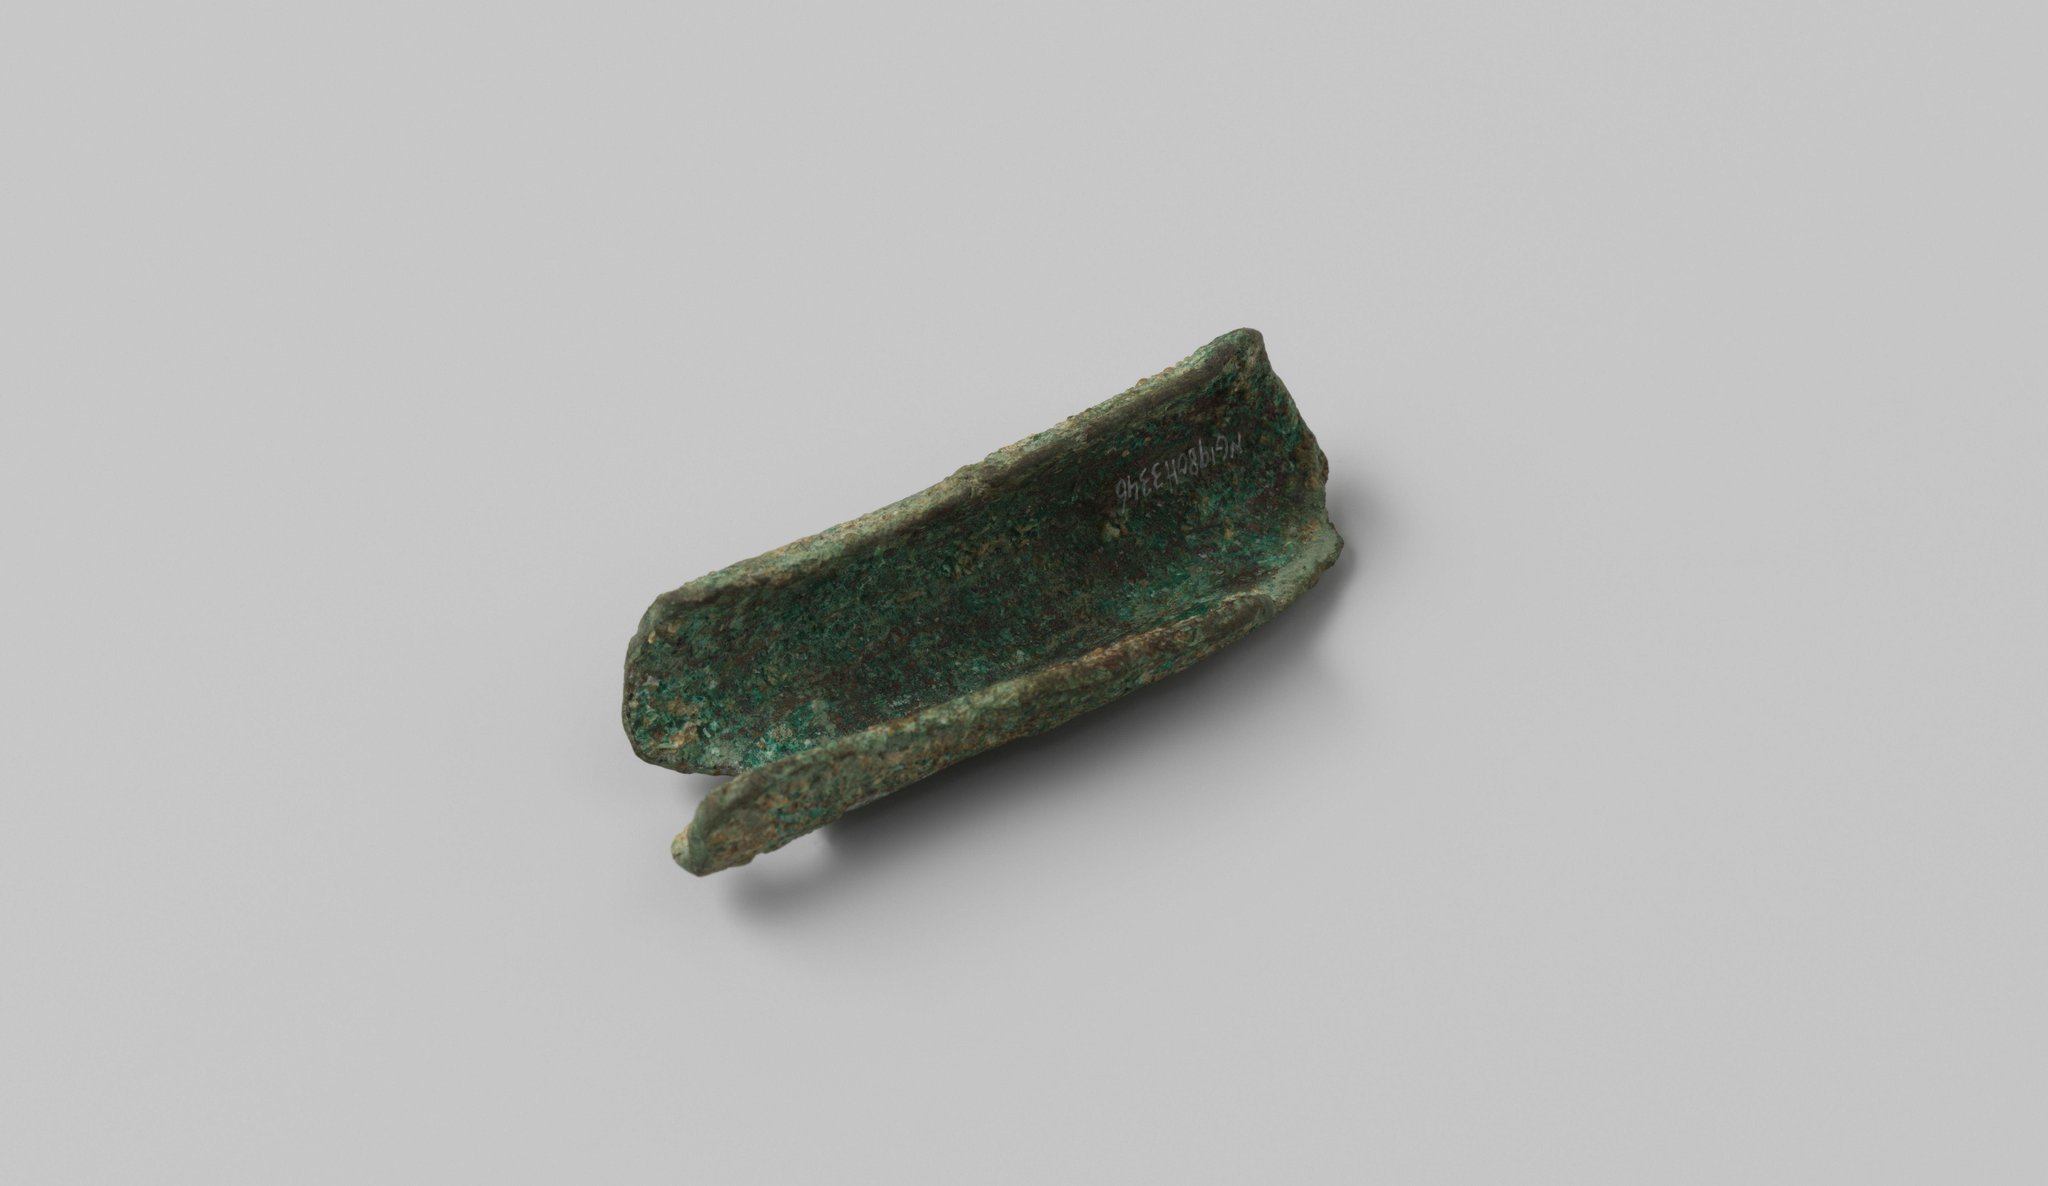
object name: tap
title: Kraan uit het wrak van de Oost-Indiëvaarder Hollandia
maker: Anonymous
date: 1700-1743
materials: copper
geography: netherlands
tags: verenigde oostindische compagnie, hollandia (schip), annet